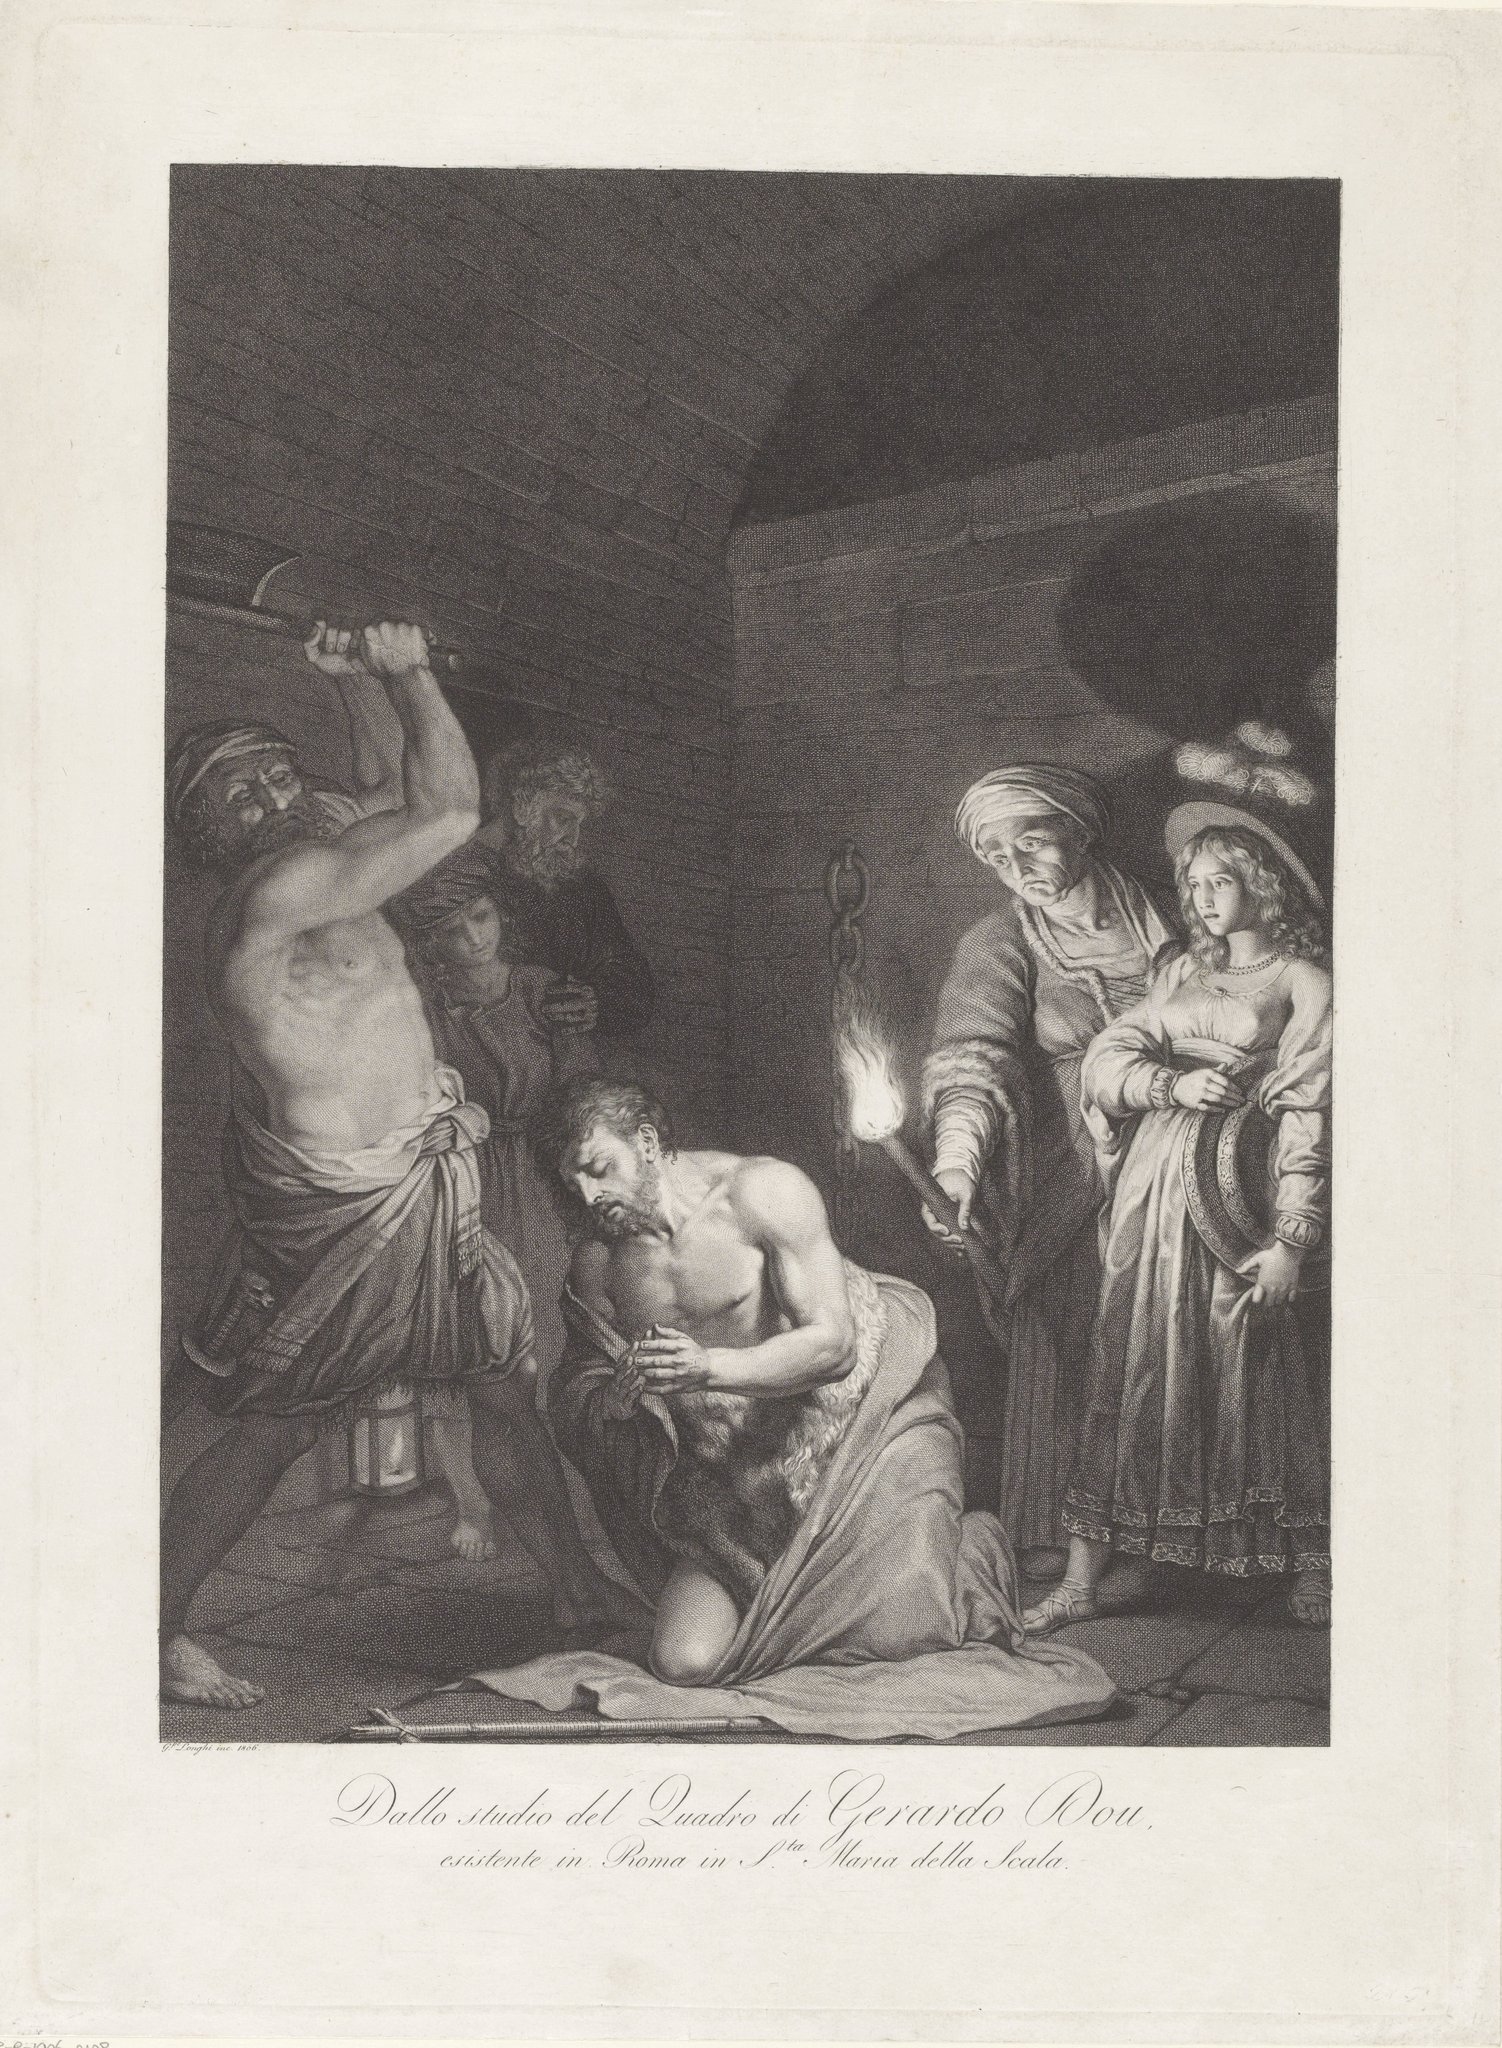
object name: print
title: Onthoofding van Johannes de Doper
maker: giuseppe longhi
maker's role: draughtsman, print maker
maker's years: 1766-1831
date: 1806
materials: paper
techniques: etching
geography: italy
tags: the beheading of john the baptist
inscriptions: collector's mark: Lugt 2228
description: Een beul staat op het punt het hoofd van Johannes de Doper af te hakken met een bijl. Johannes zit geknield op de grond en is in gebed. Op de achtergrond staat Salome klaar met een schaal.